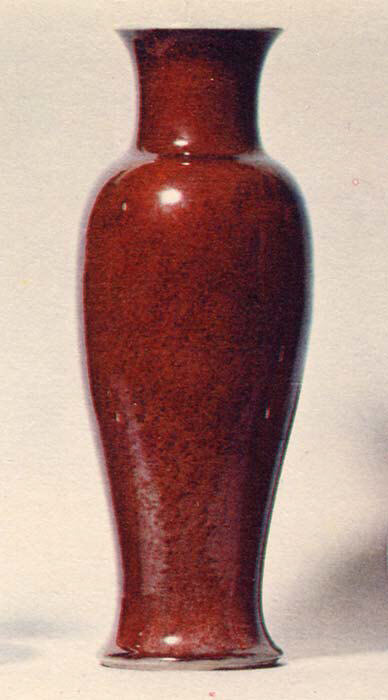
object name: vase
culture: chinese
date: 1667-1733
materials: glaze, porcelain